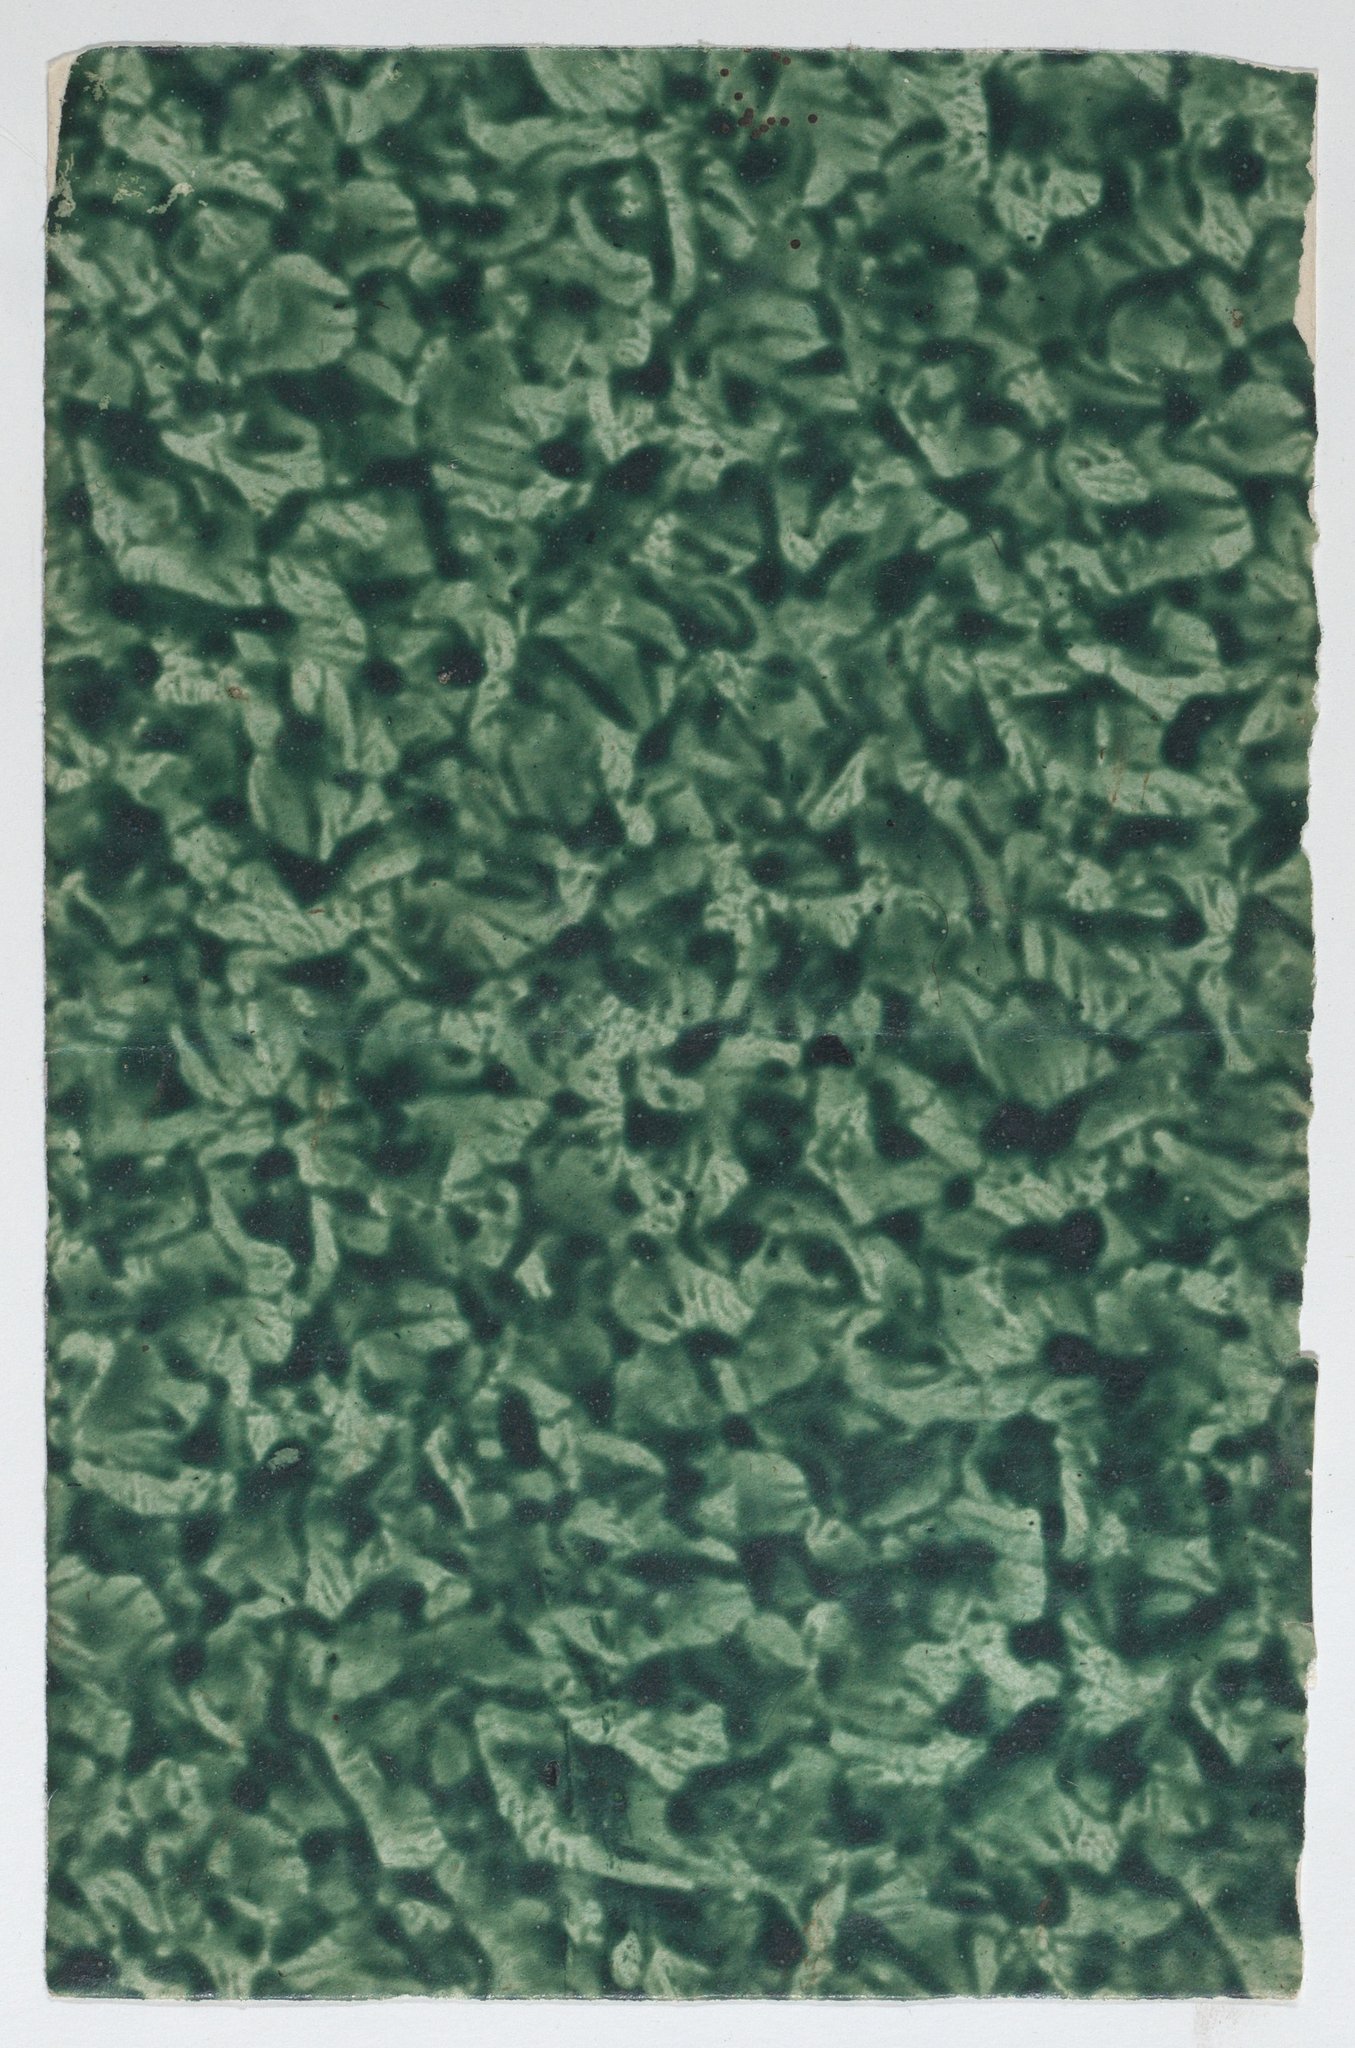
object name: print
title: Green paste paper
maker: Anonymous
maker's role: artist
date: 1701-1800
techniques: relief print